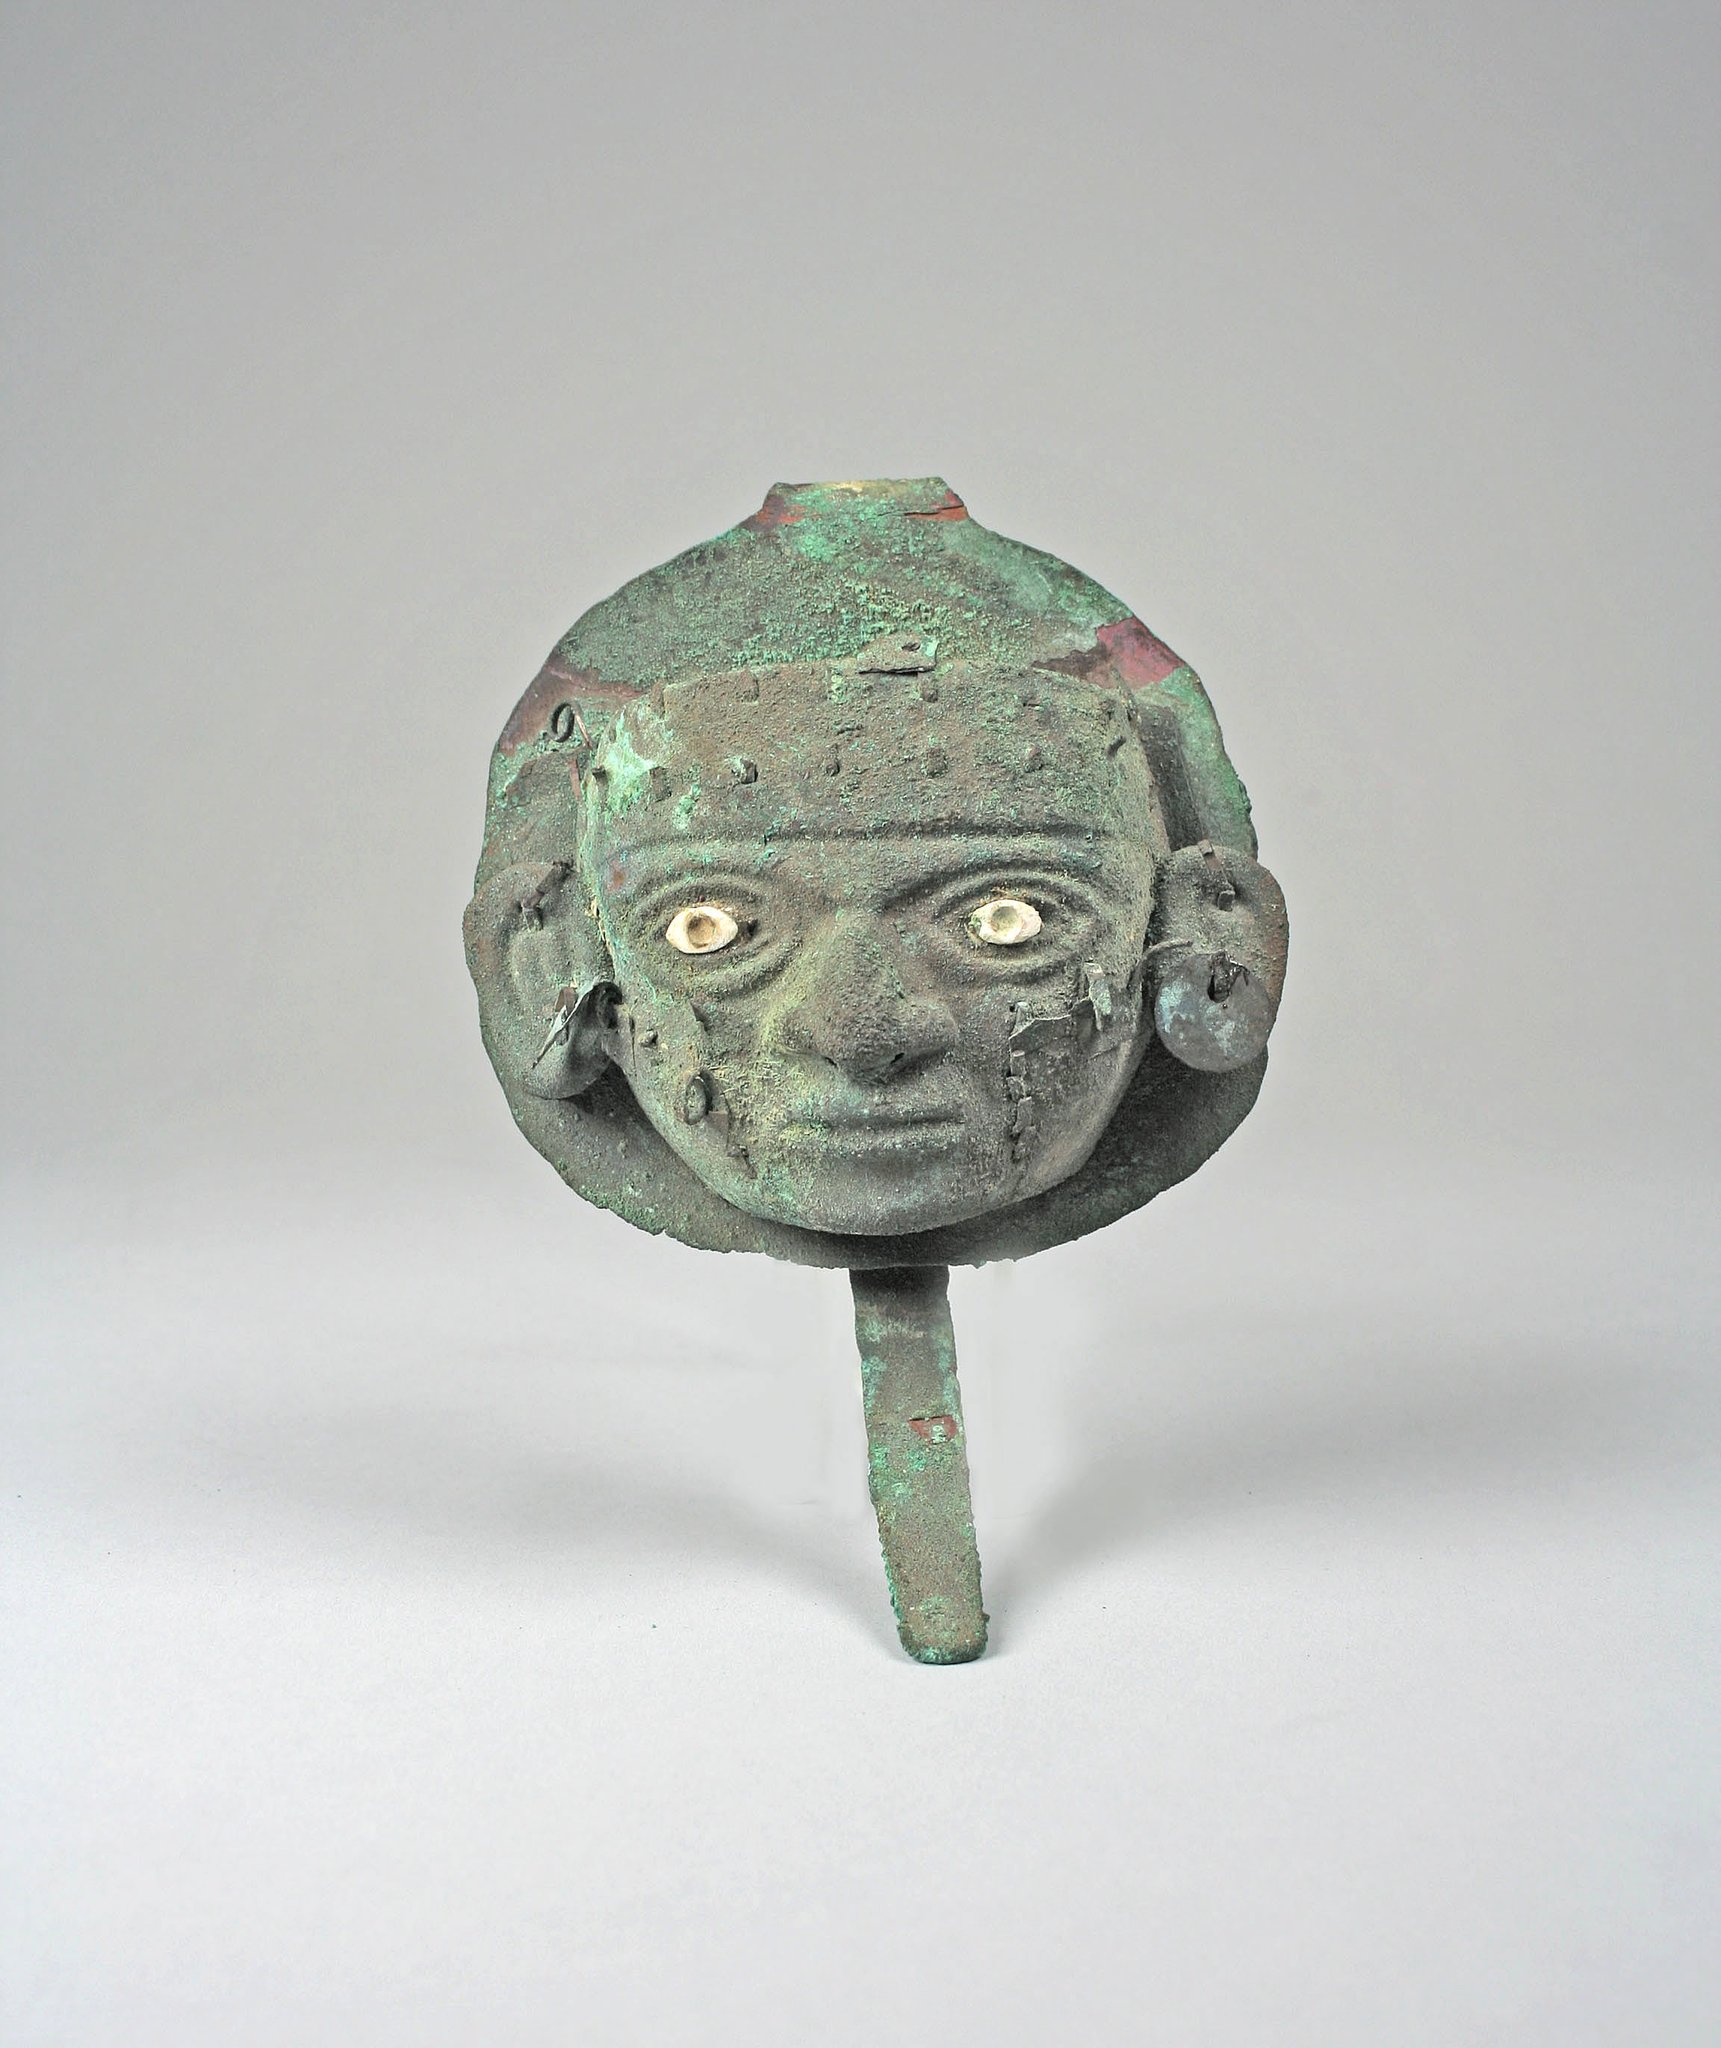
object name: ornament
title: Face Mask Ornament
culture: moche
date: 501-700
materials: gilt copper, shell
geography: peru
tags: faces